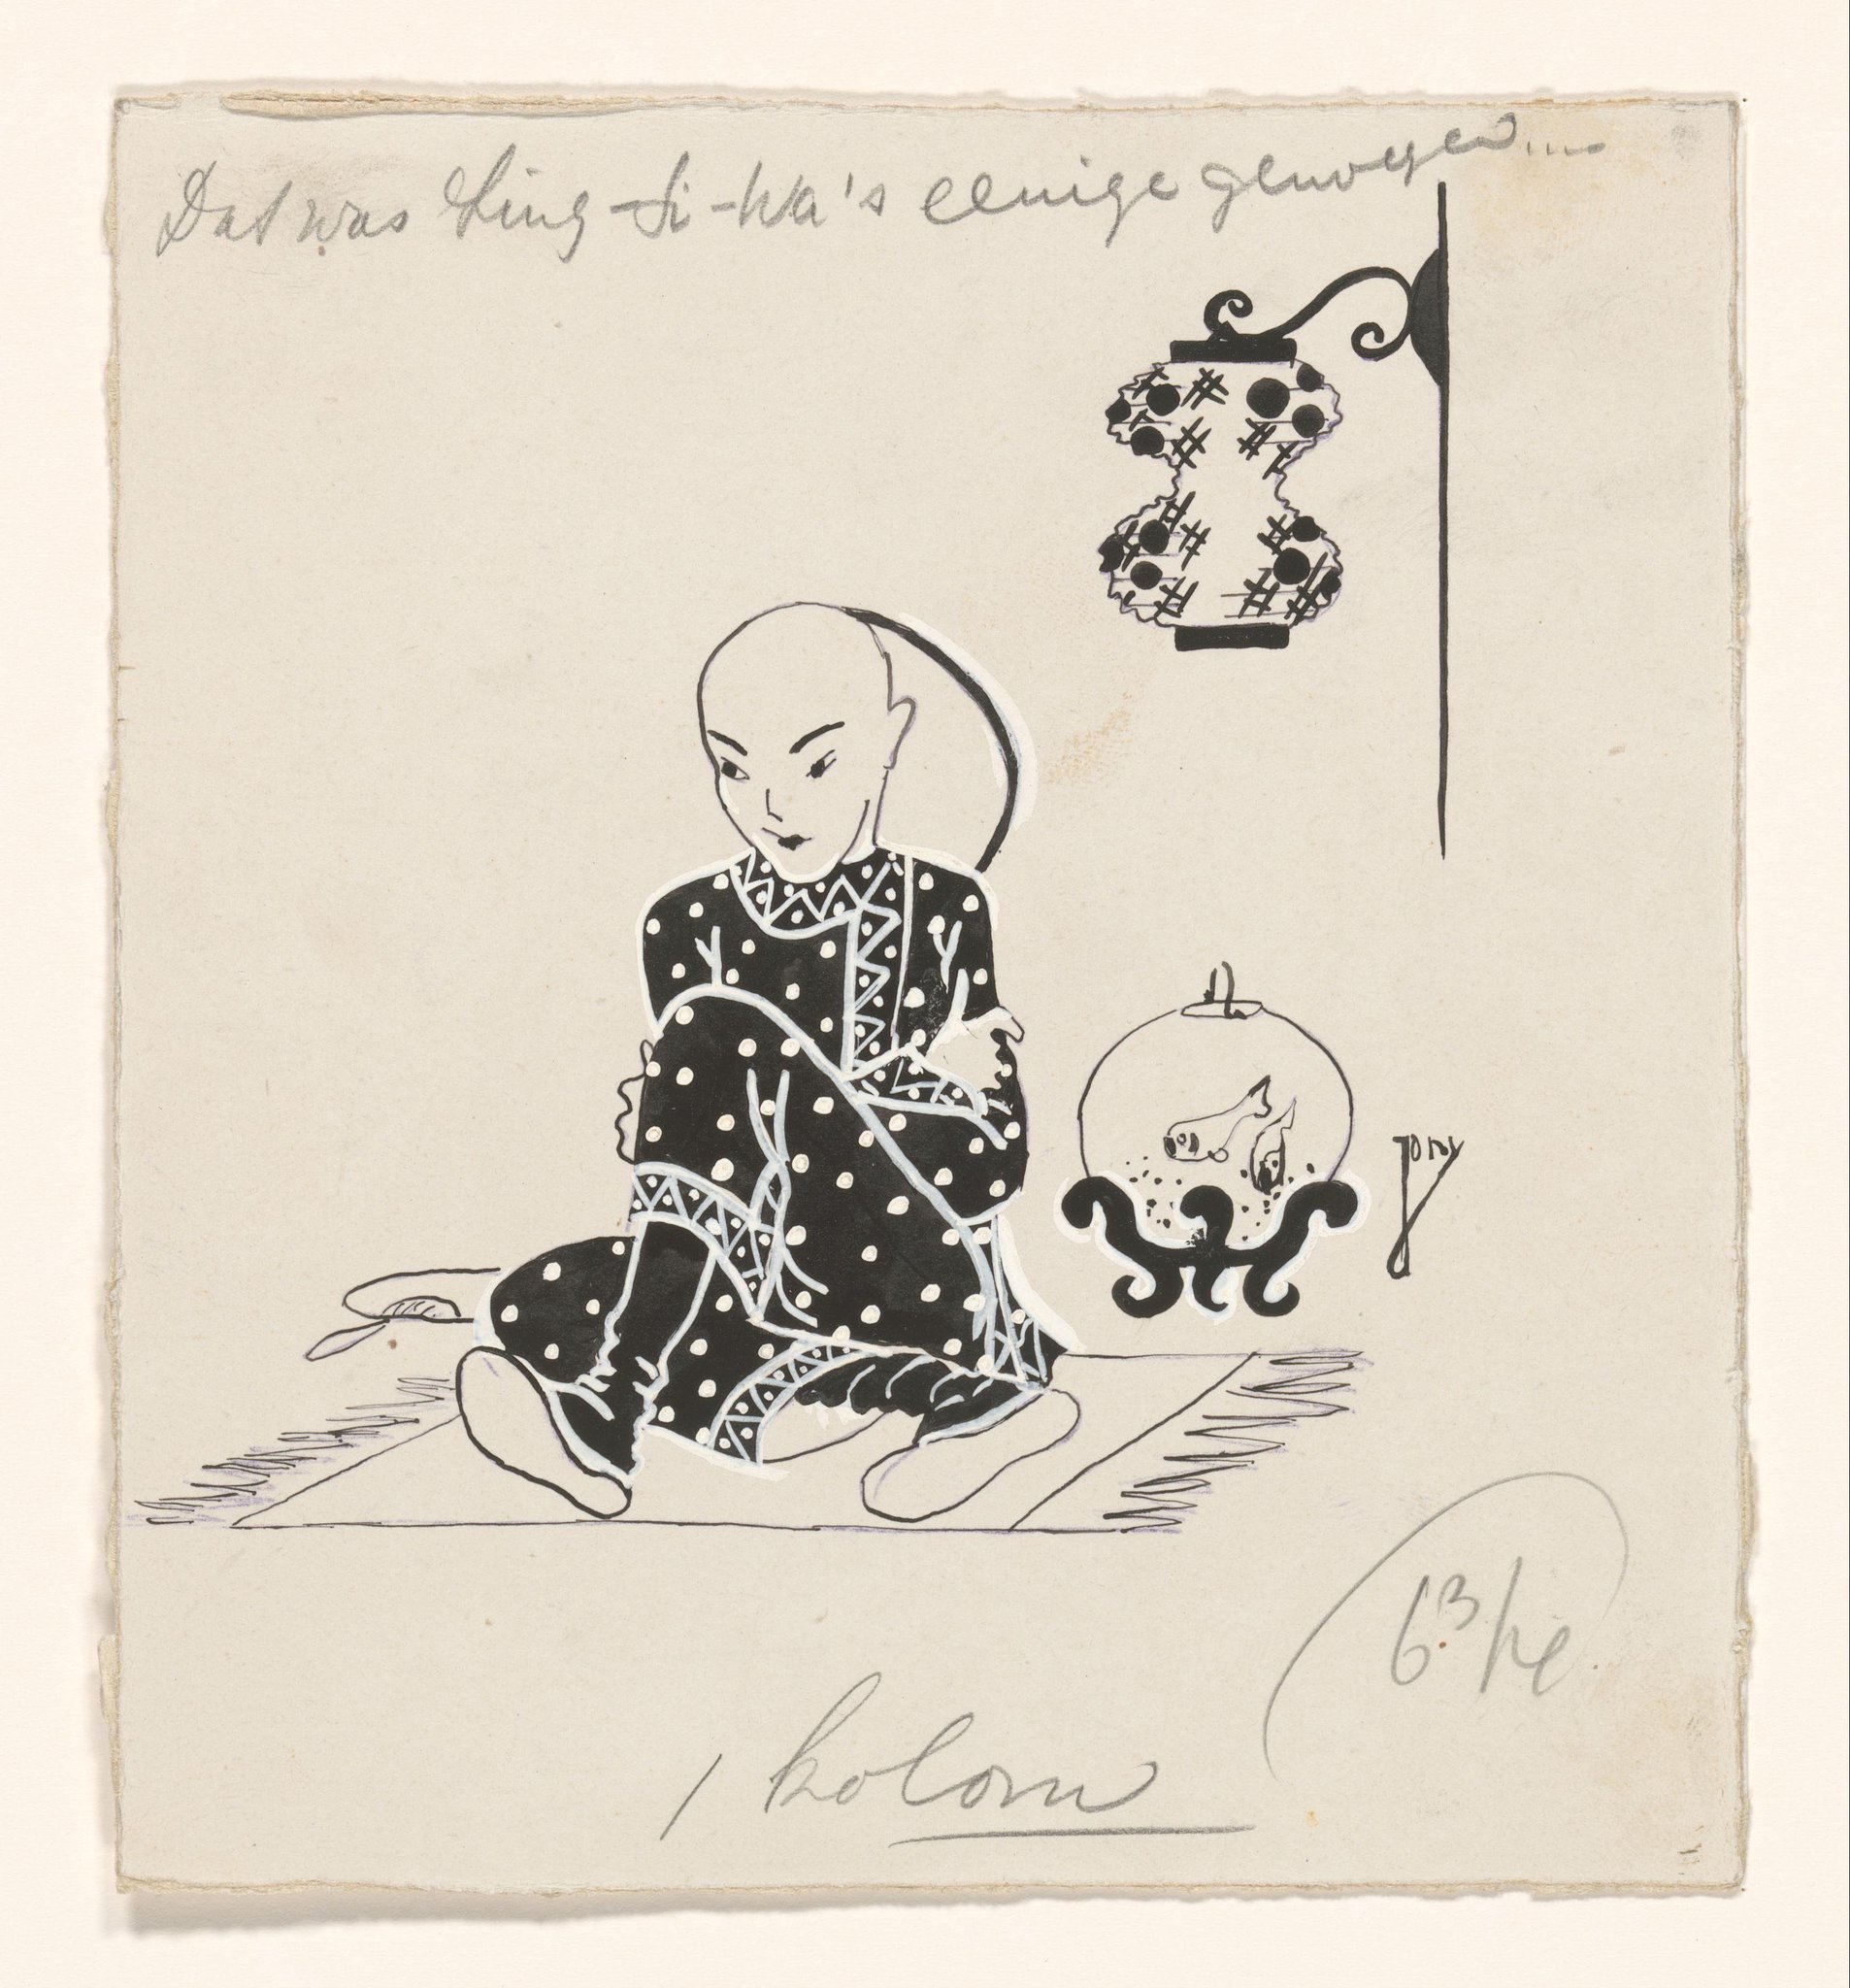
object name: illustratie ontwerp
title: Ling-Ti-Wa zittend naast een vissenkom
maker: jony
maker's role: draughtsman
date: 1875-1925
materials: paint, ink, paper, pencil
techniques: brush, pen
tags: fish bowl, sitting on the ground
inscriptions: signature: ‘Jony’, collector's mark: Lugt 2228a, annotation: ‘Dat was Ling-Ti-Wa's eenige genoegen...’, :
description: Ling-Ti-Wa zit op een vloerkleed naast een vissenkom. Aan de wand hangt een lampion.